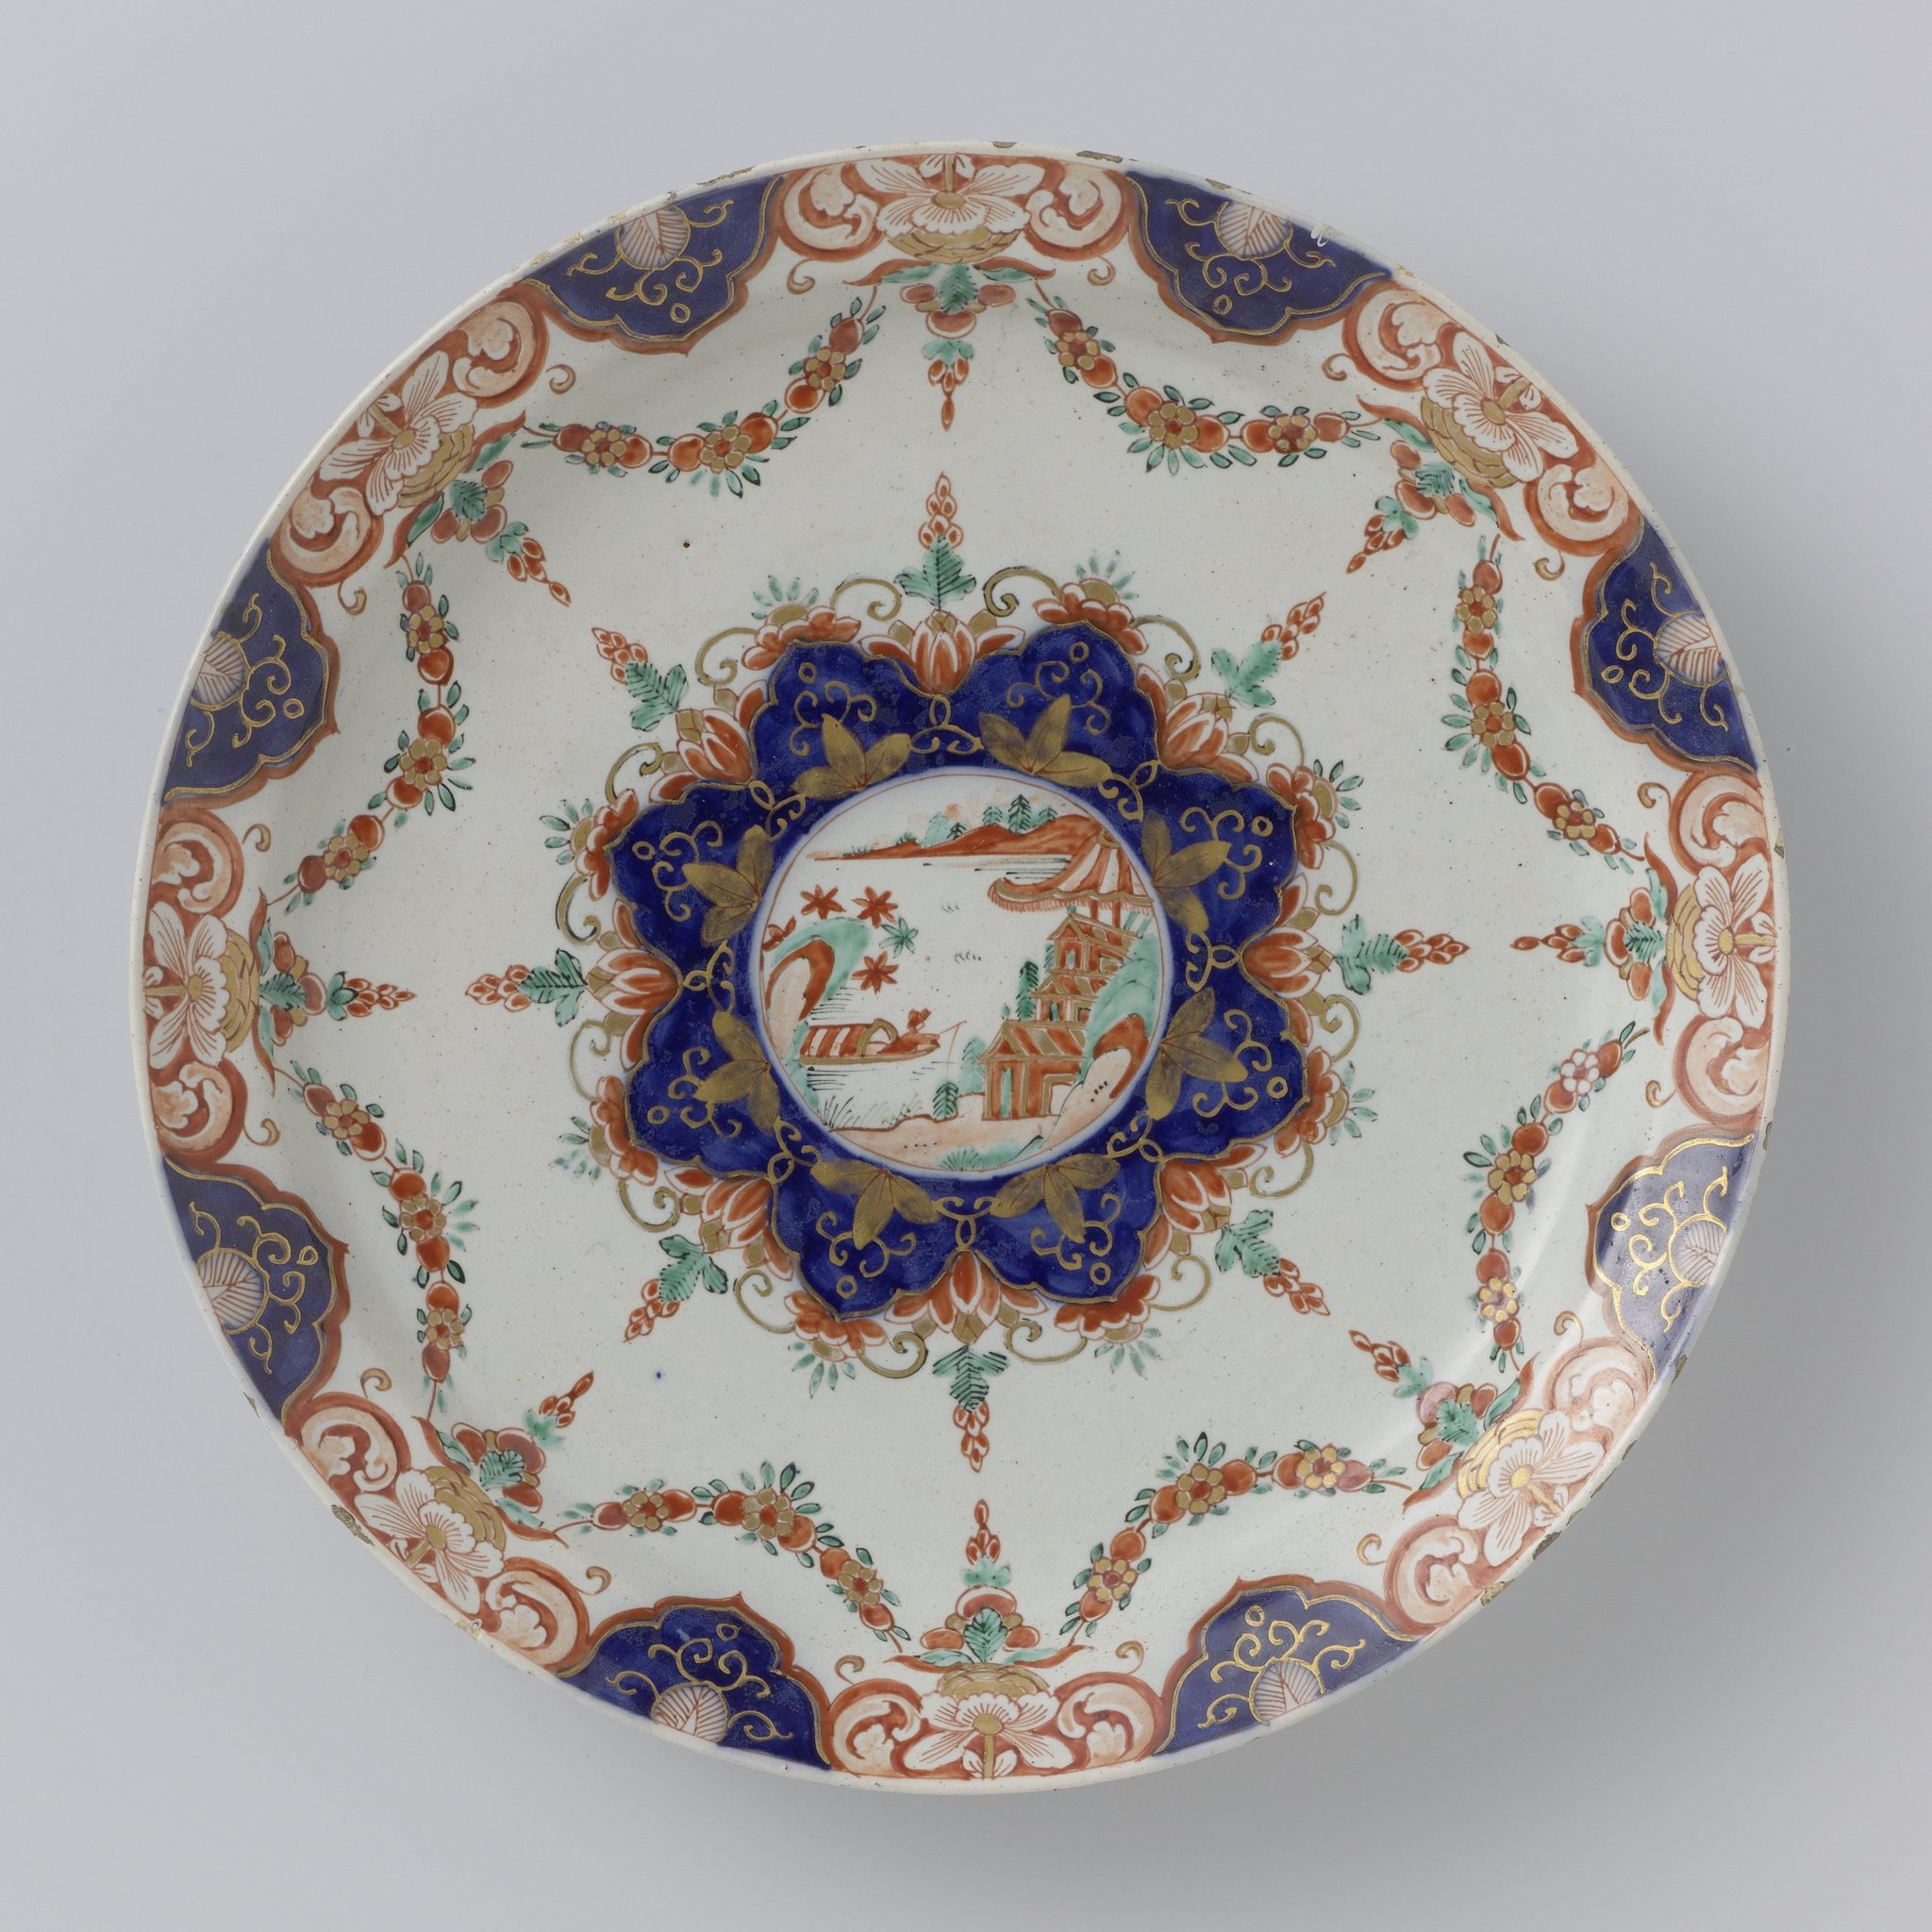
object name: plate dish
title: Bord van veelkleurig beschilderde faïence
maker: Anonymous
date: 1700-1725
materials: faience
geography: delft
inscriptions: inscription: ‘A'dam RM 5 b’, collector's mark: ‘collection loudon’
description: Bord van faïence. Veelkleurig beschilderd met een chinees waterlandschap en lambrequins, in imari kleuren.